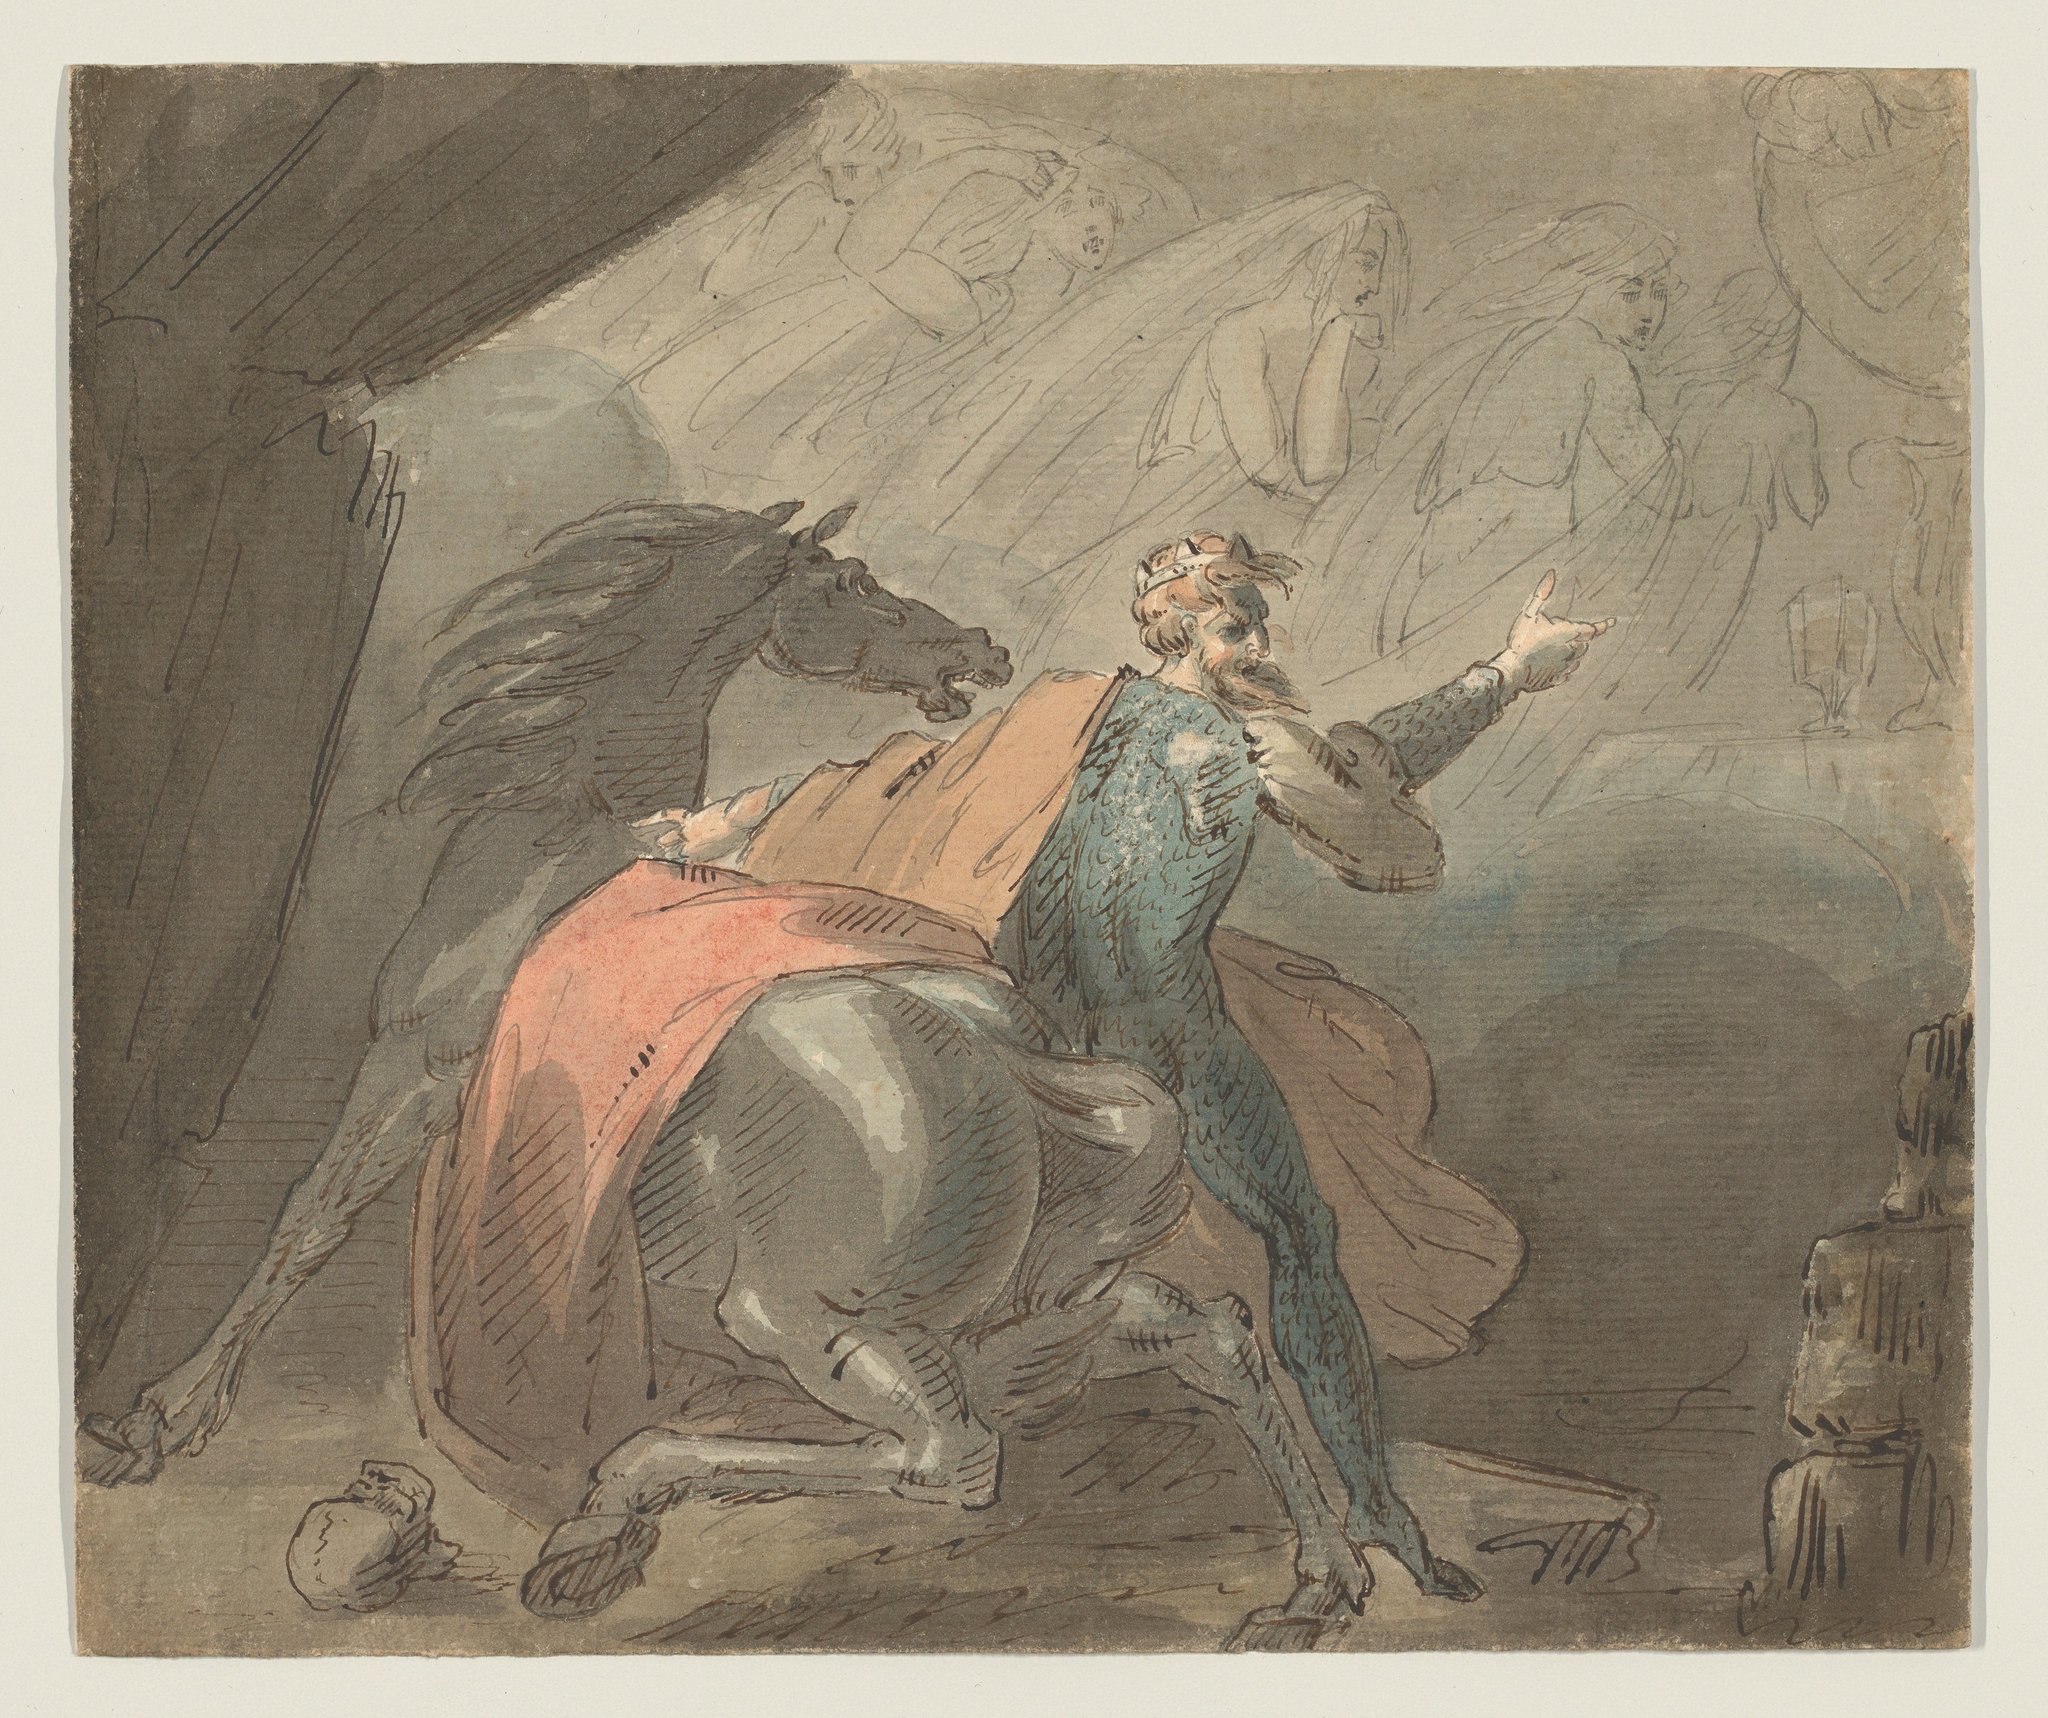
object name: drawing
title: A king with his horse, alarmed by ghostly women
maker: william hamilton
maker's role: artist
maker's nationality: british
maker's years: 1751-1801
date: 1770-1780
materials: graphite, ink, watercolor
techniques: brush, pen, wash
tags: kings,men,women,horses